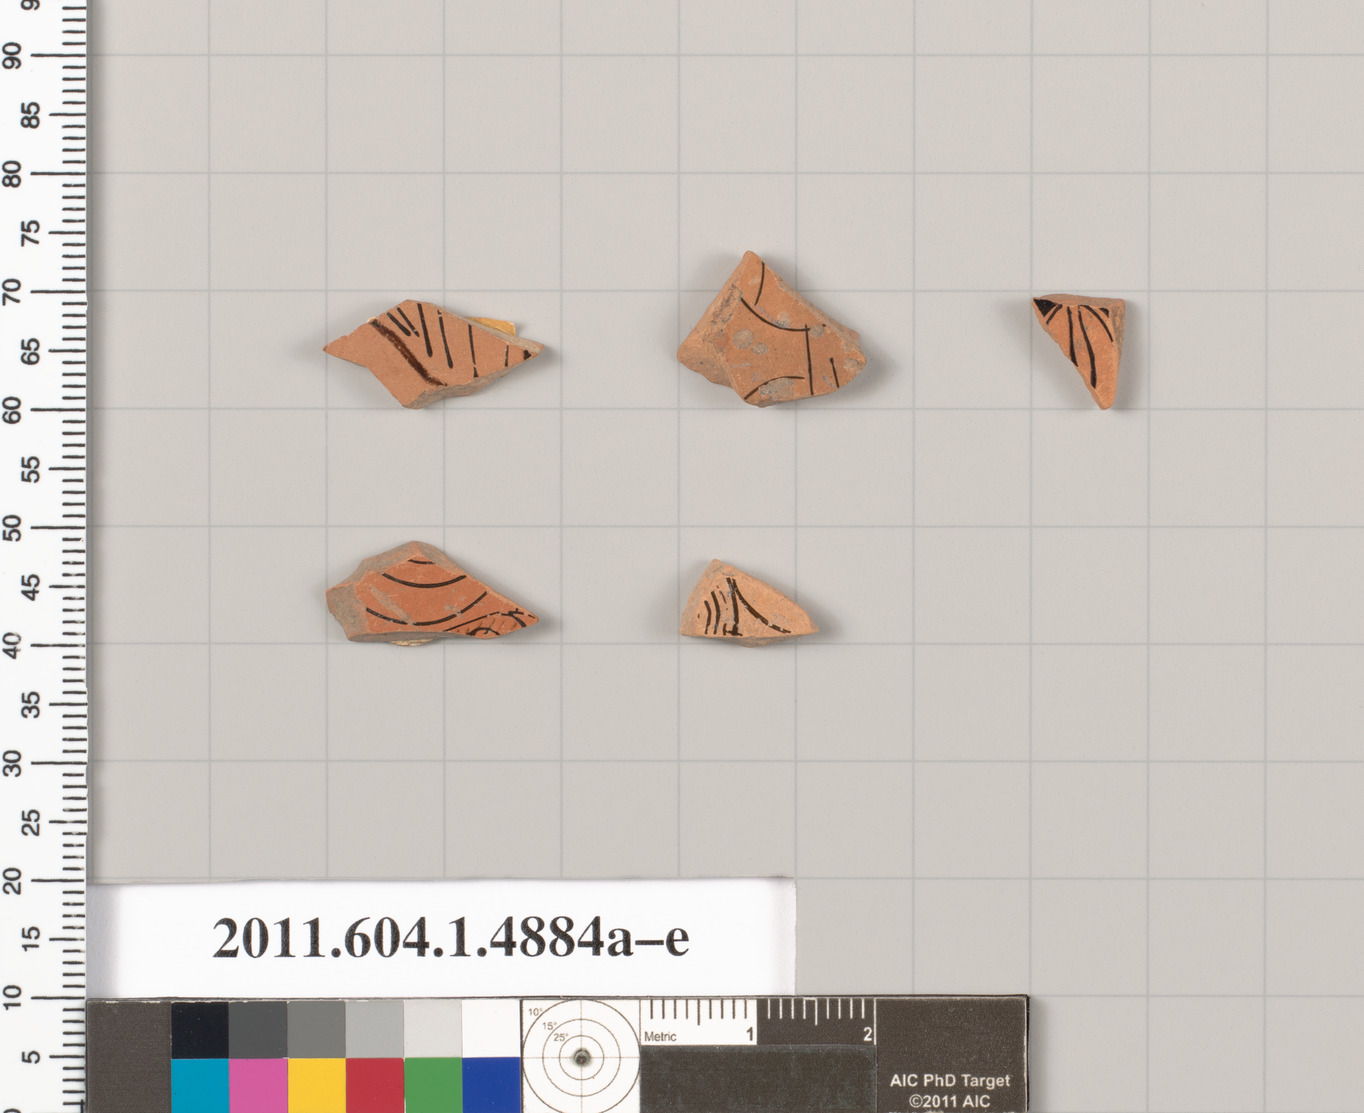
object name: kylix fragment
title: Terracotta fragments of kylikes (drinking cups)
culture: greek, attic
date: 490-470 BCE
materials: terracotta